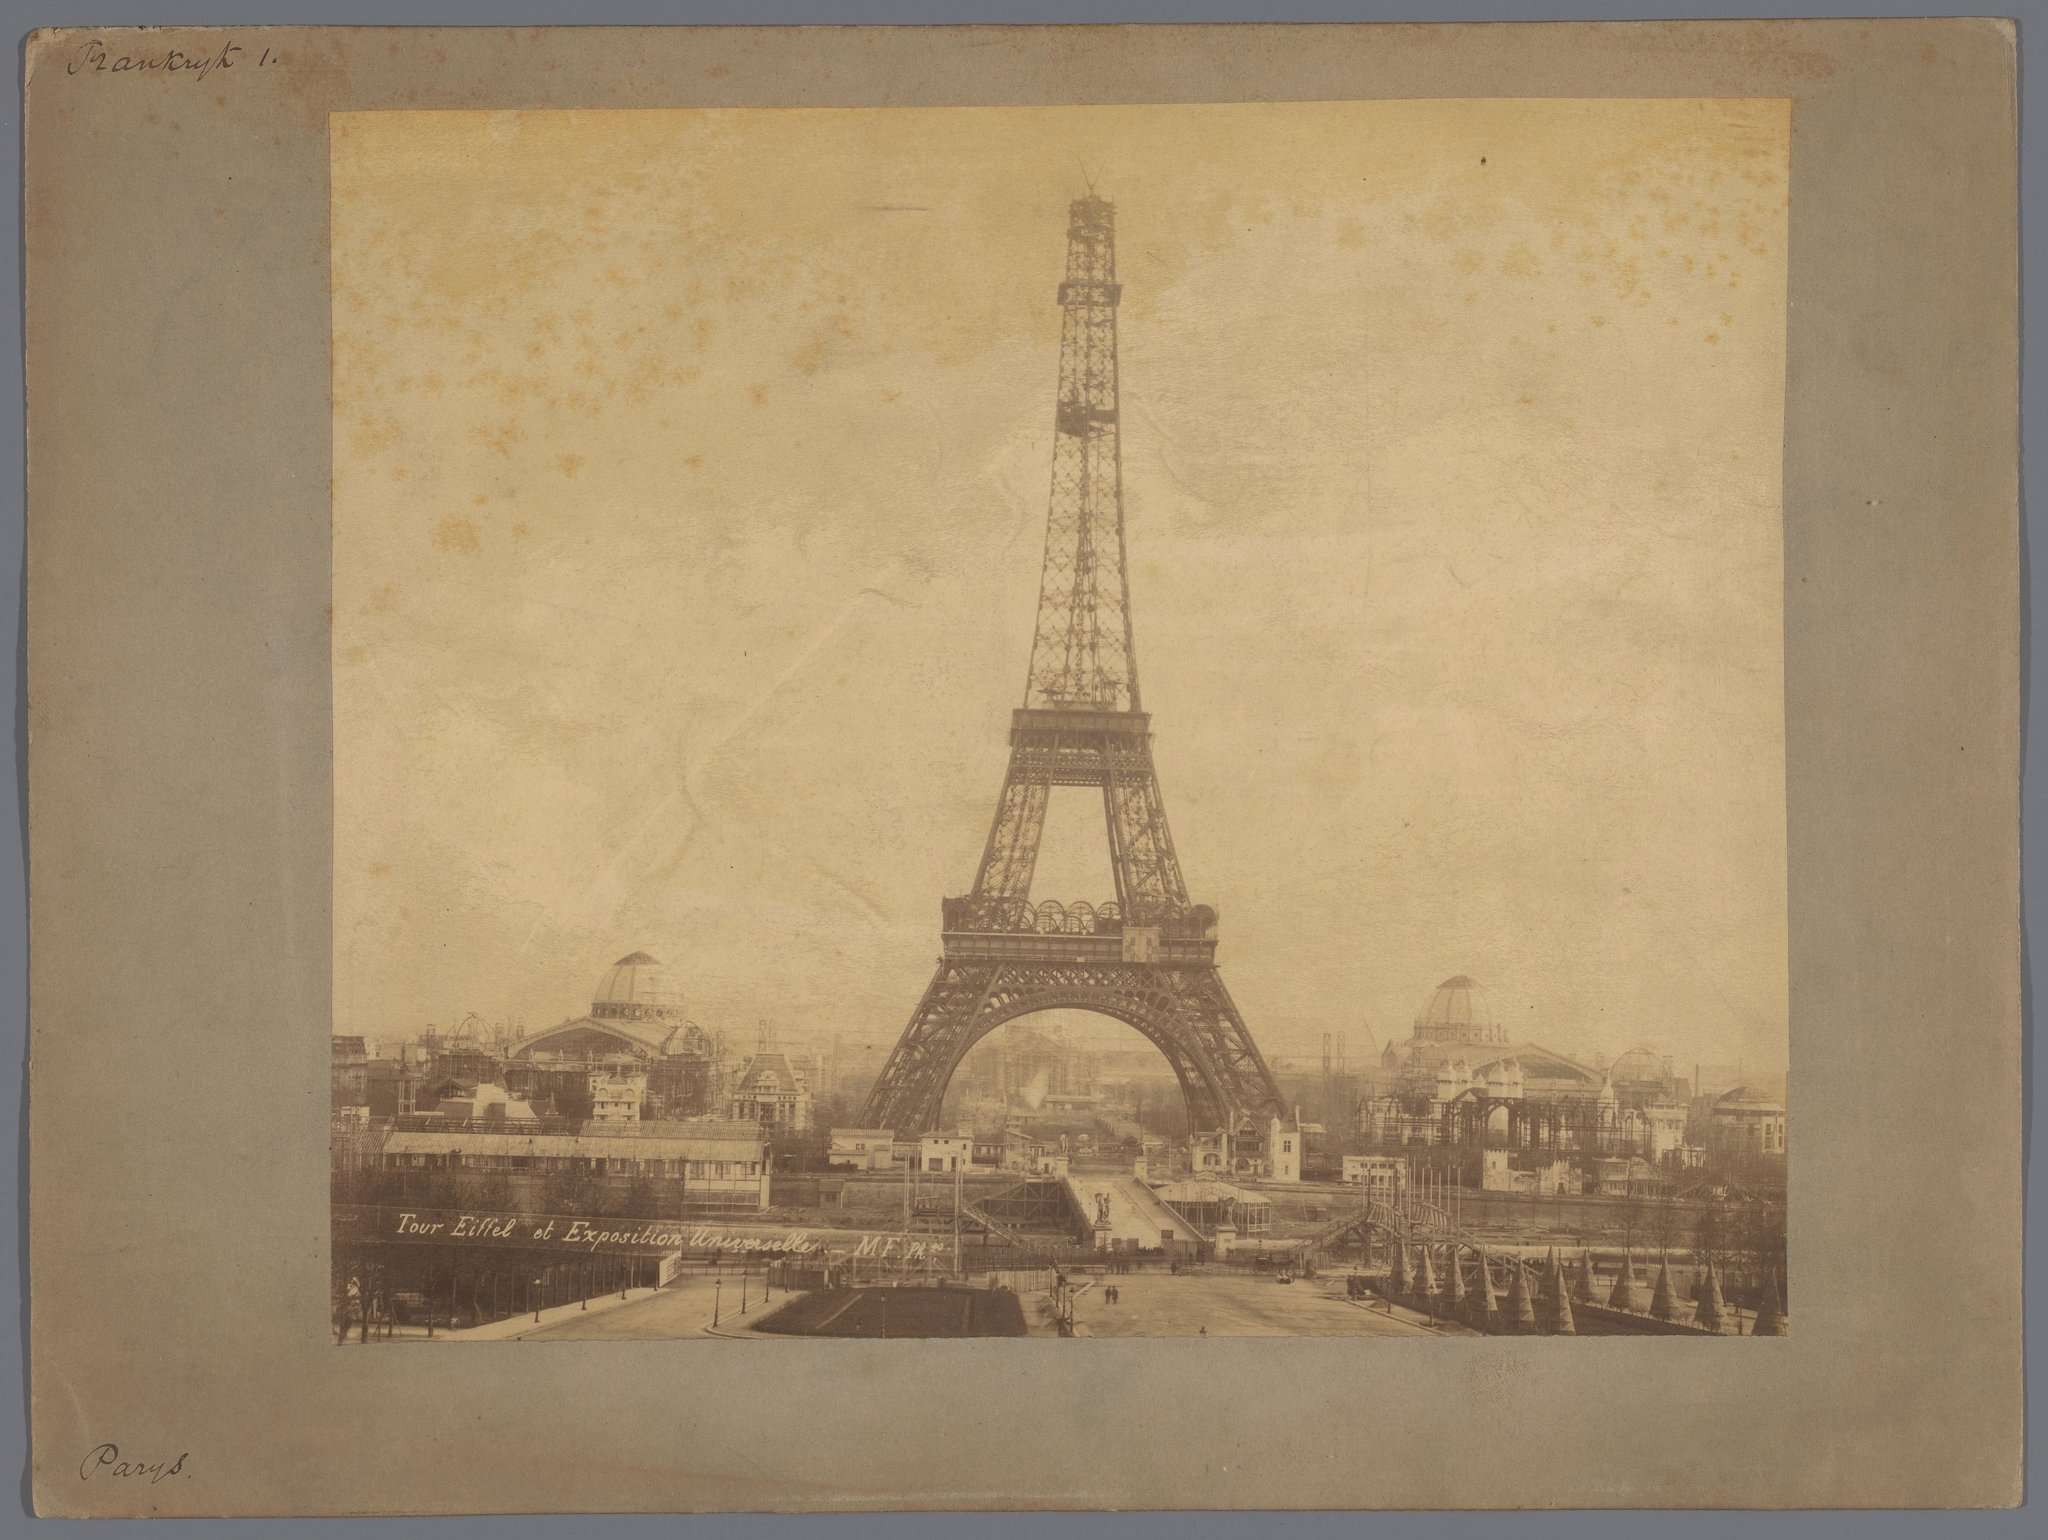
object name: photograph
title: Gezicht op de Eiffeltoren tijdens de opbouw van de Wereldtentoonstelling te Parijs in 1889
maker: Anonymous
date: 1887-1889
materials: cardboard, photographic support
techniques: albumen print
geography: paris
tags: tower, clock tower ~ monumental adornment, world fair, world exhibition, eiffel tower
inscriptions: annotation: ‘Eiffeltoren te Parijs [...]’, annotation: ‘Franrijk 1./ Parijs’, inscription: ‘Tour Eiffel et Exposition Universelle._ MF. ph’